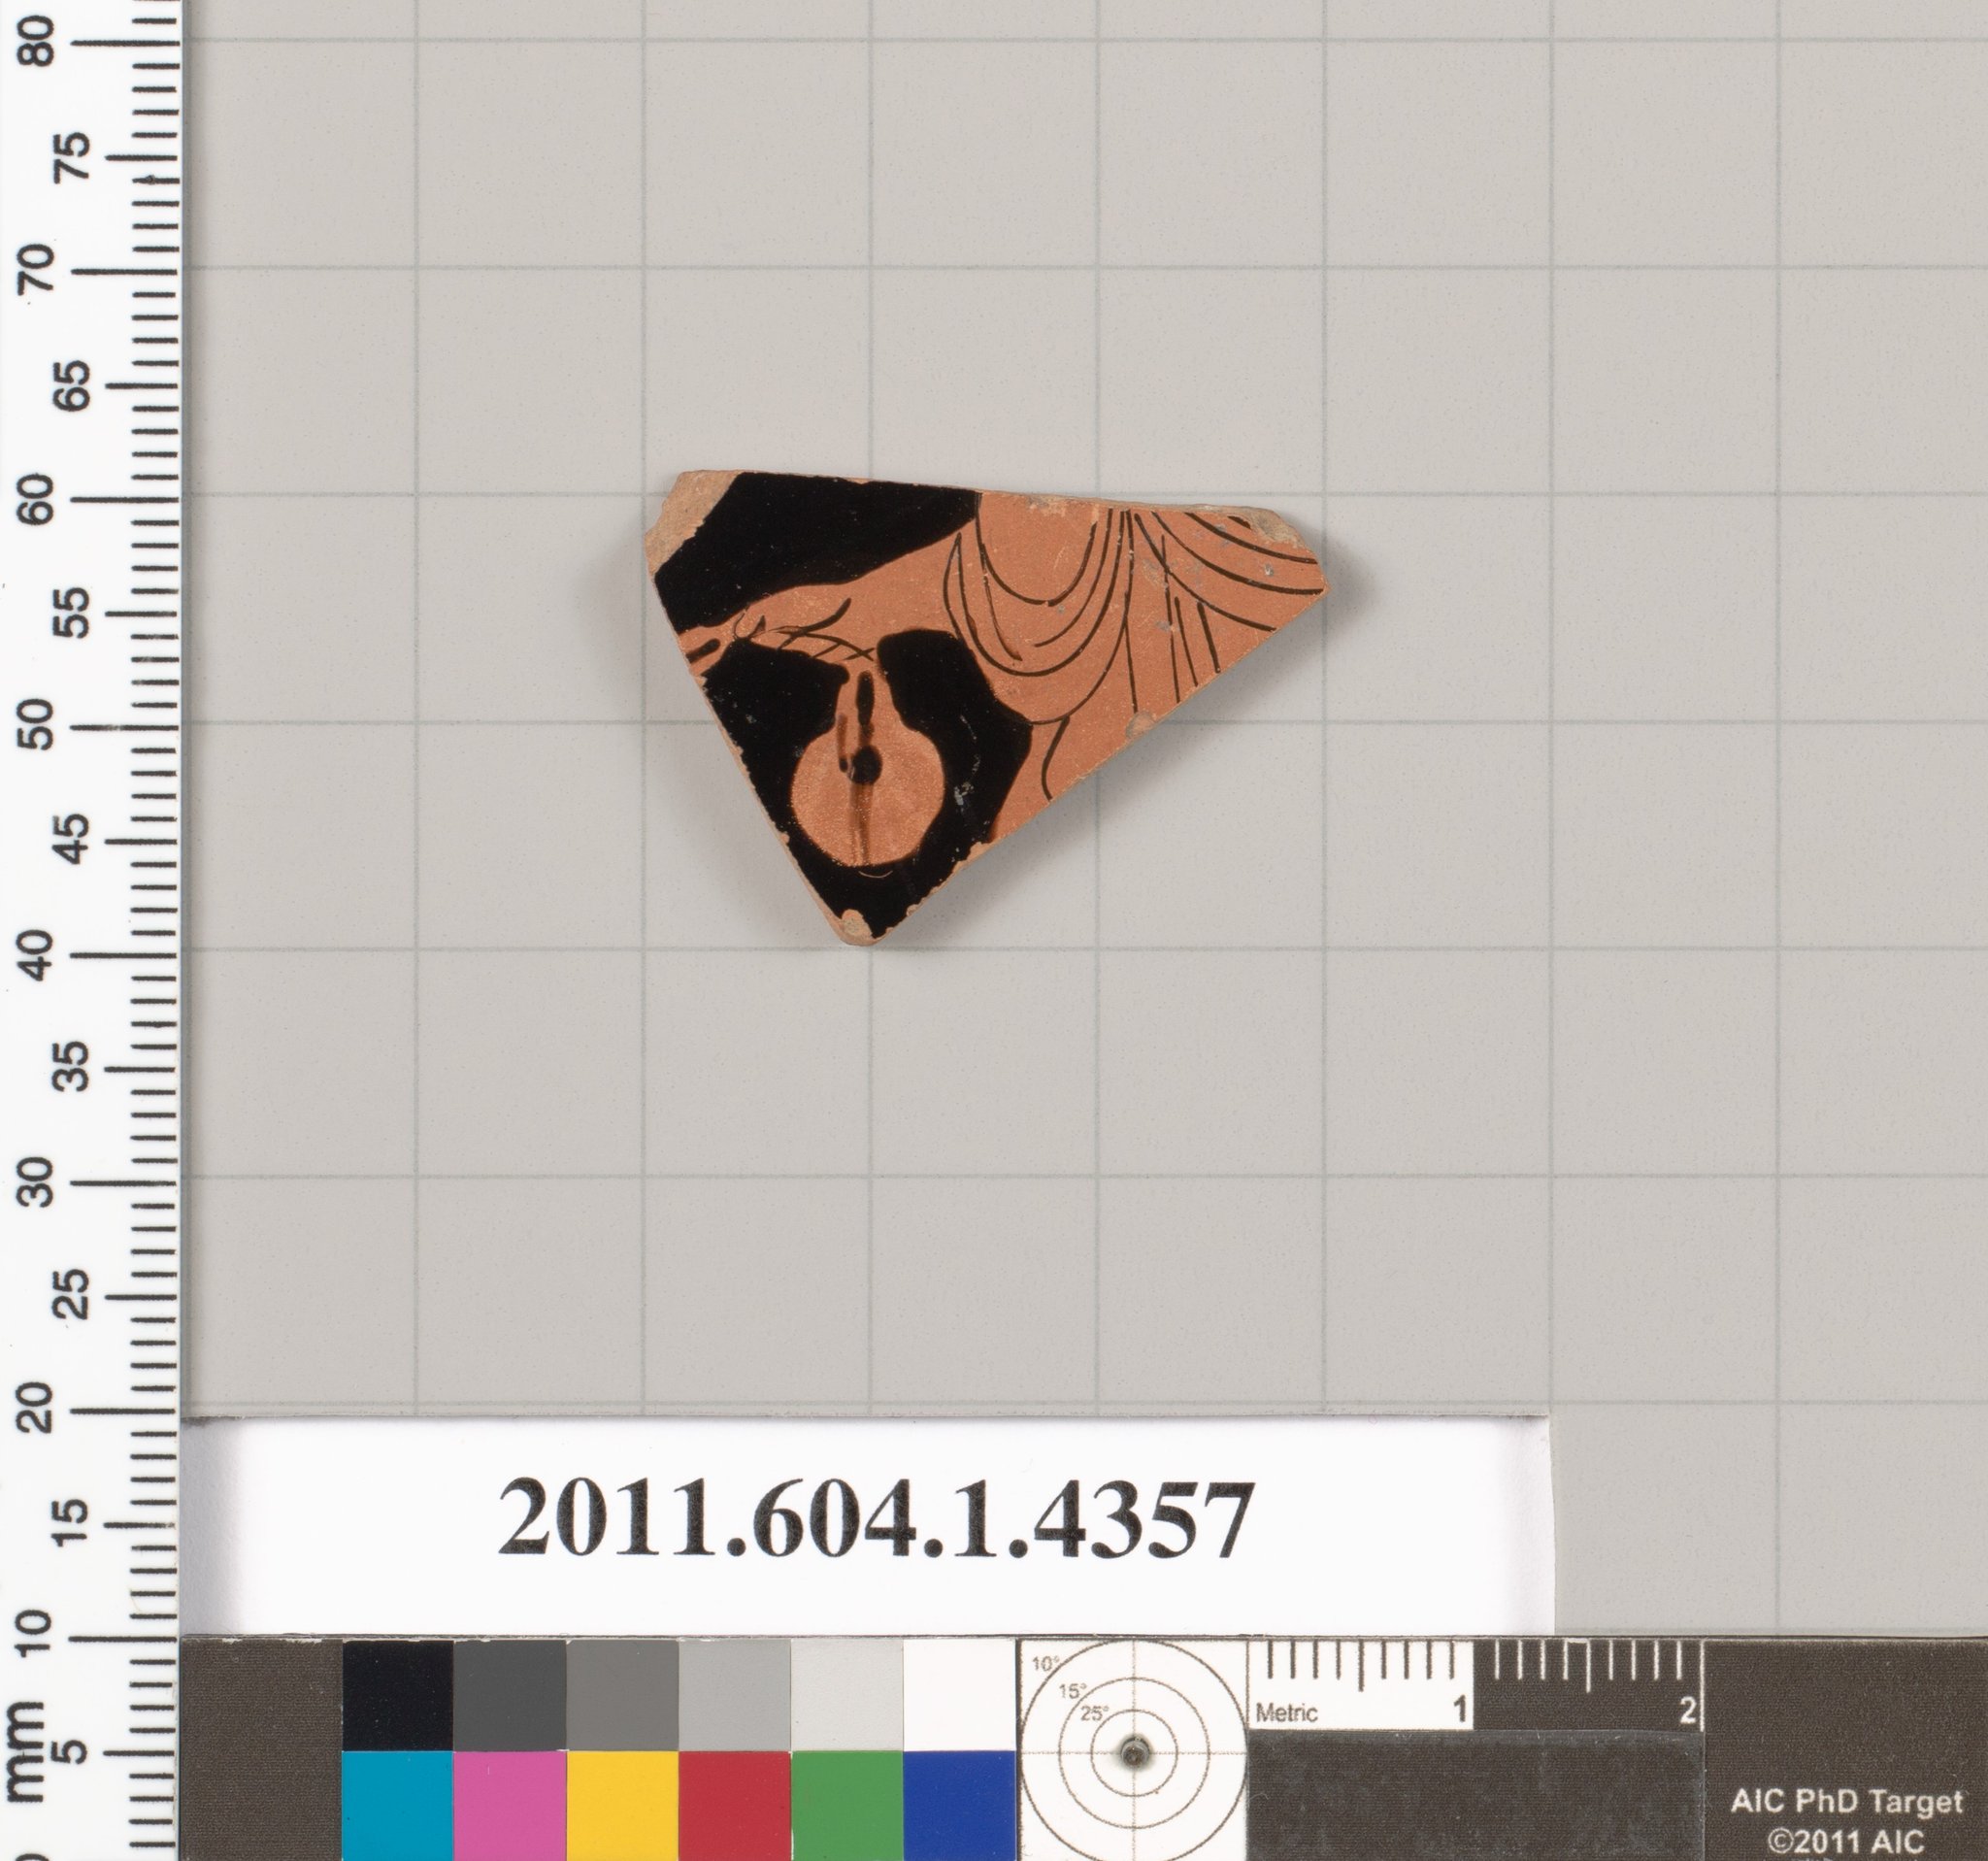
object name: kylix fragment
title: Terracotta fragment of a kylix (drinking cup)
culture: greek, attic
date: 475-451 BCE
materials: terracotta